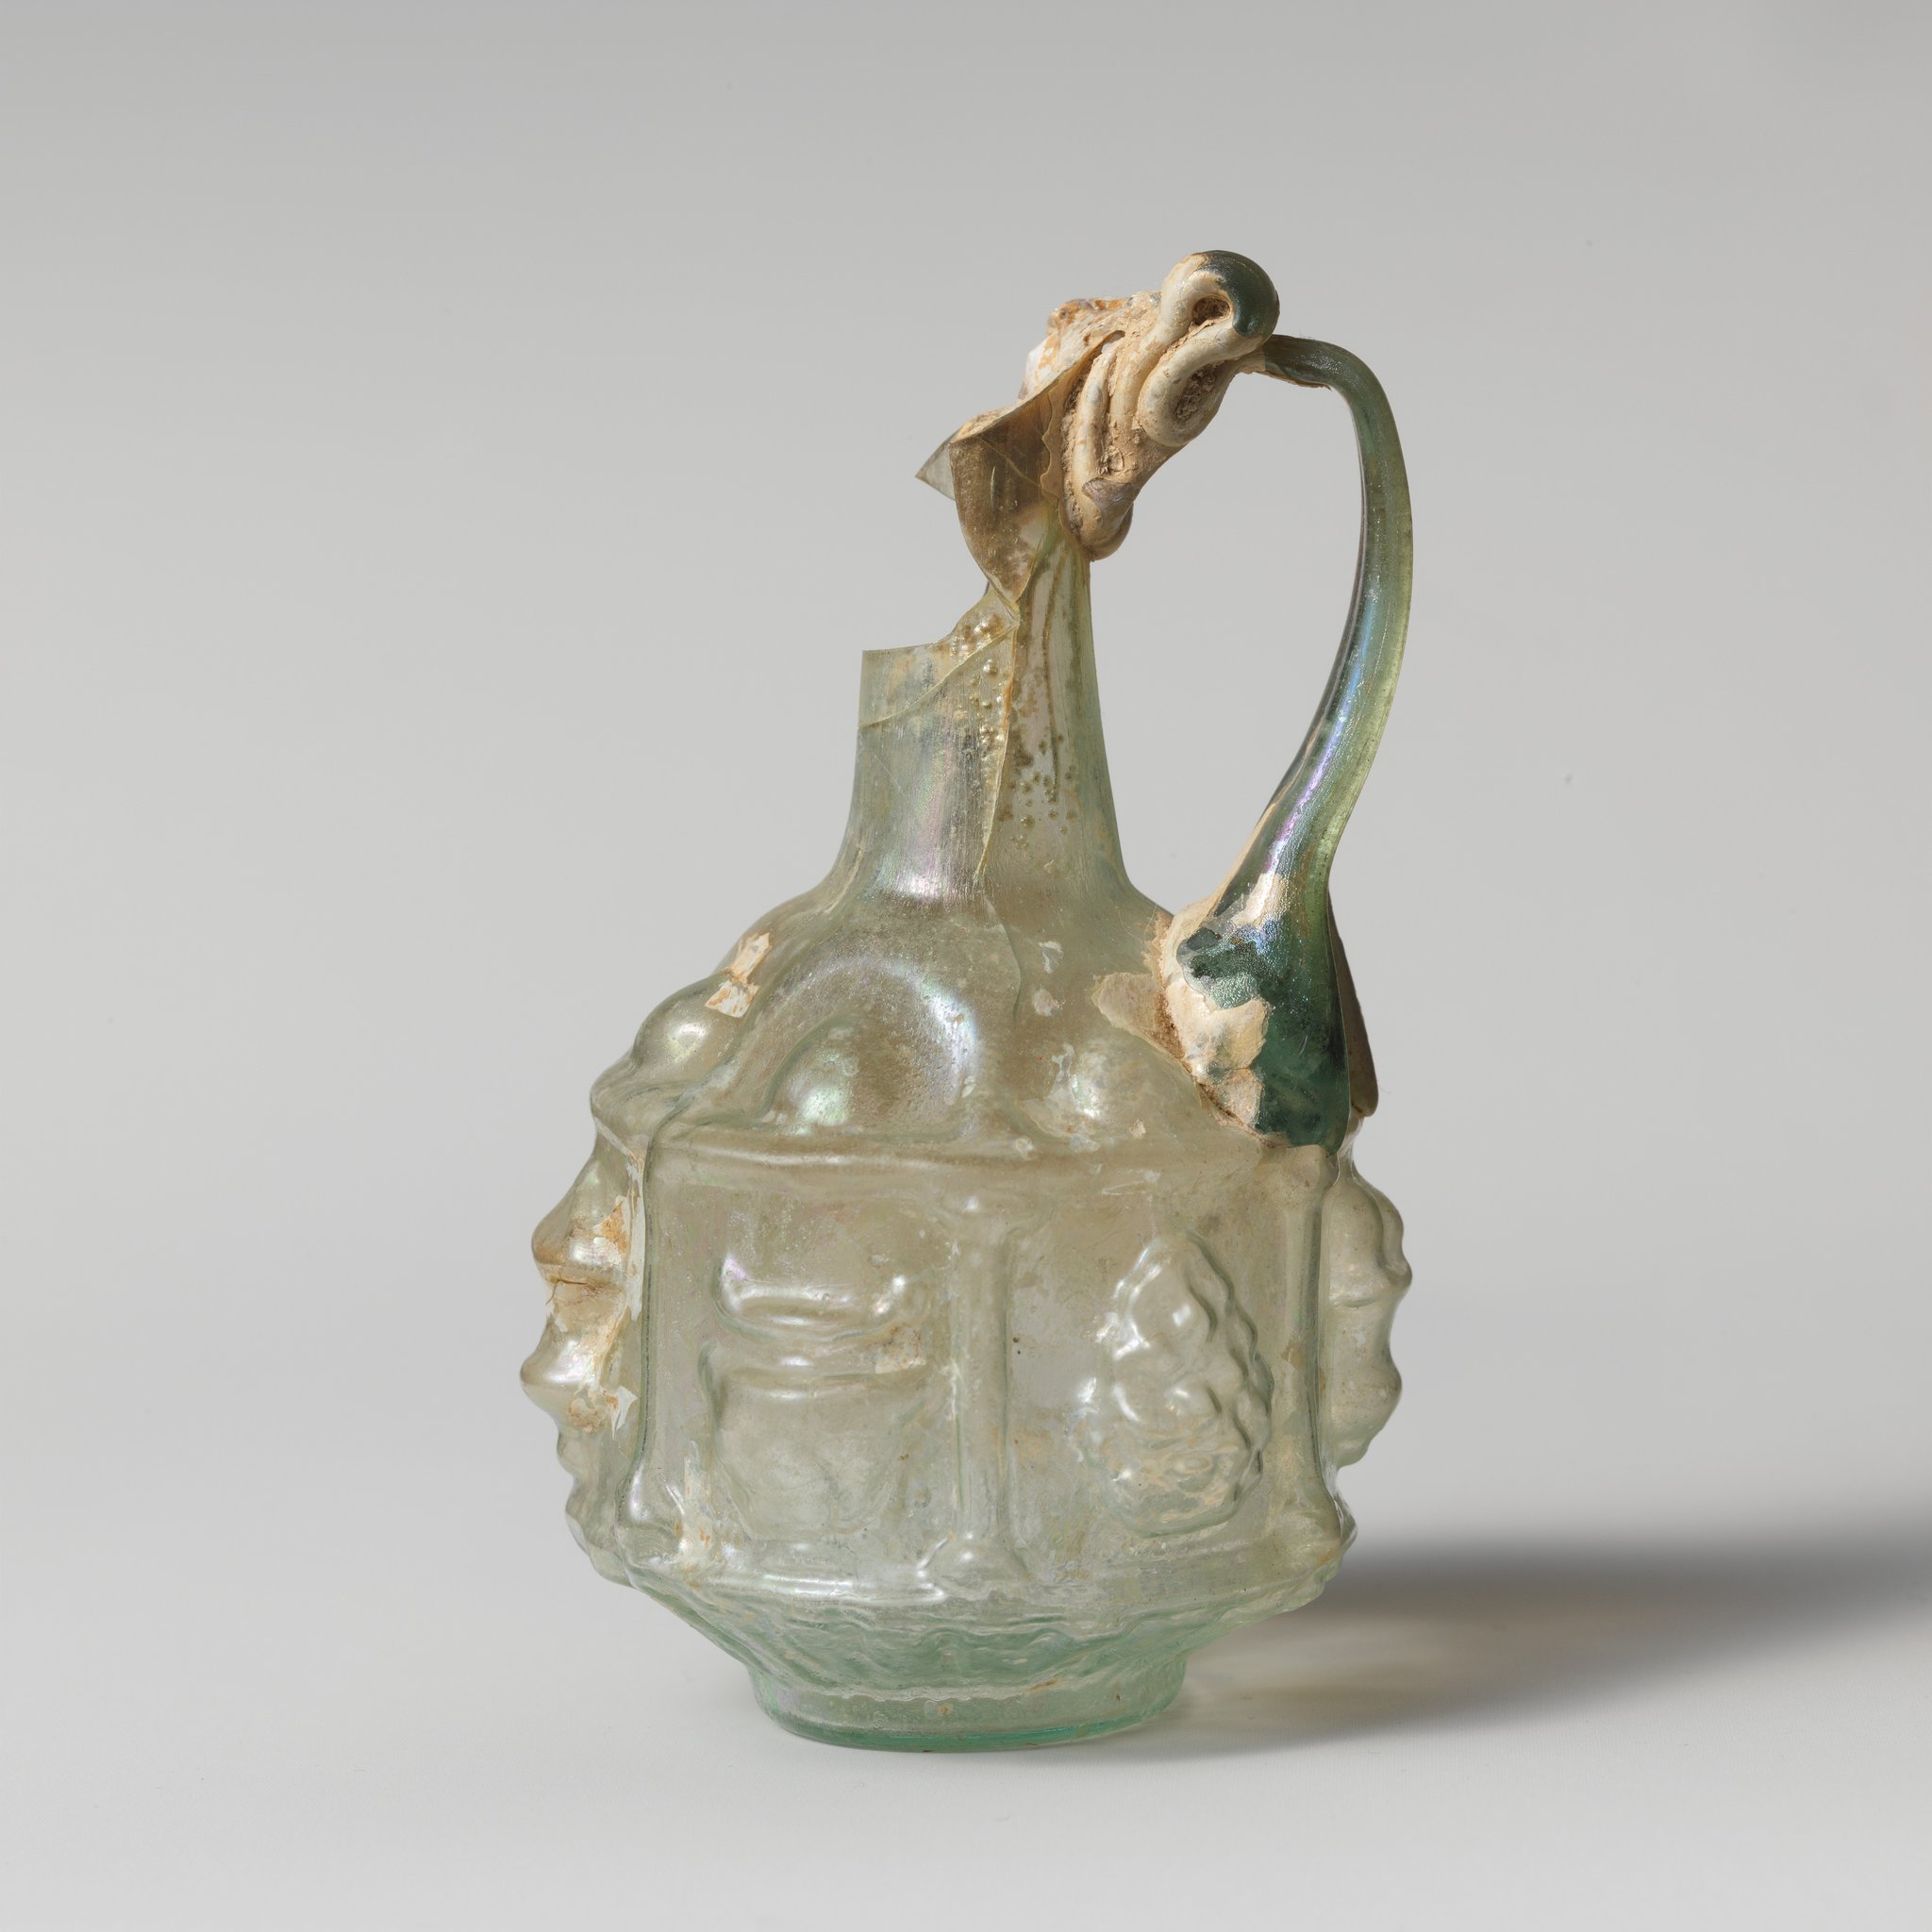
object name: jug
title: Glass jug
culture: roman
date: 1-50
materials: glass